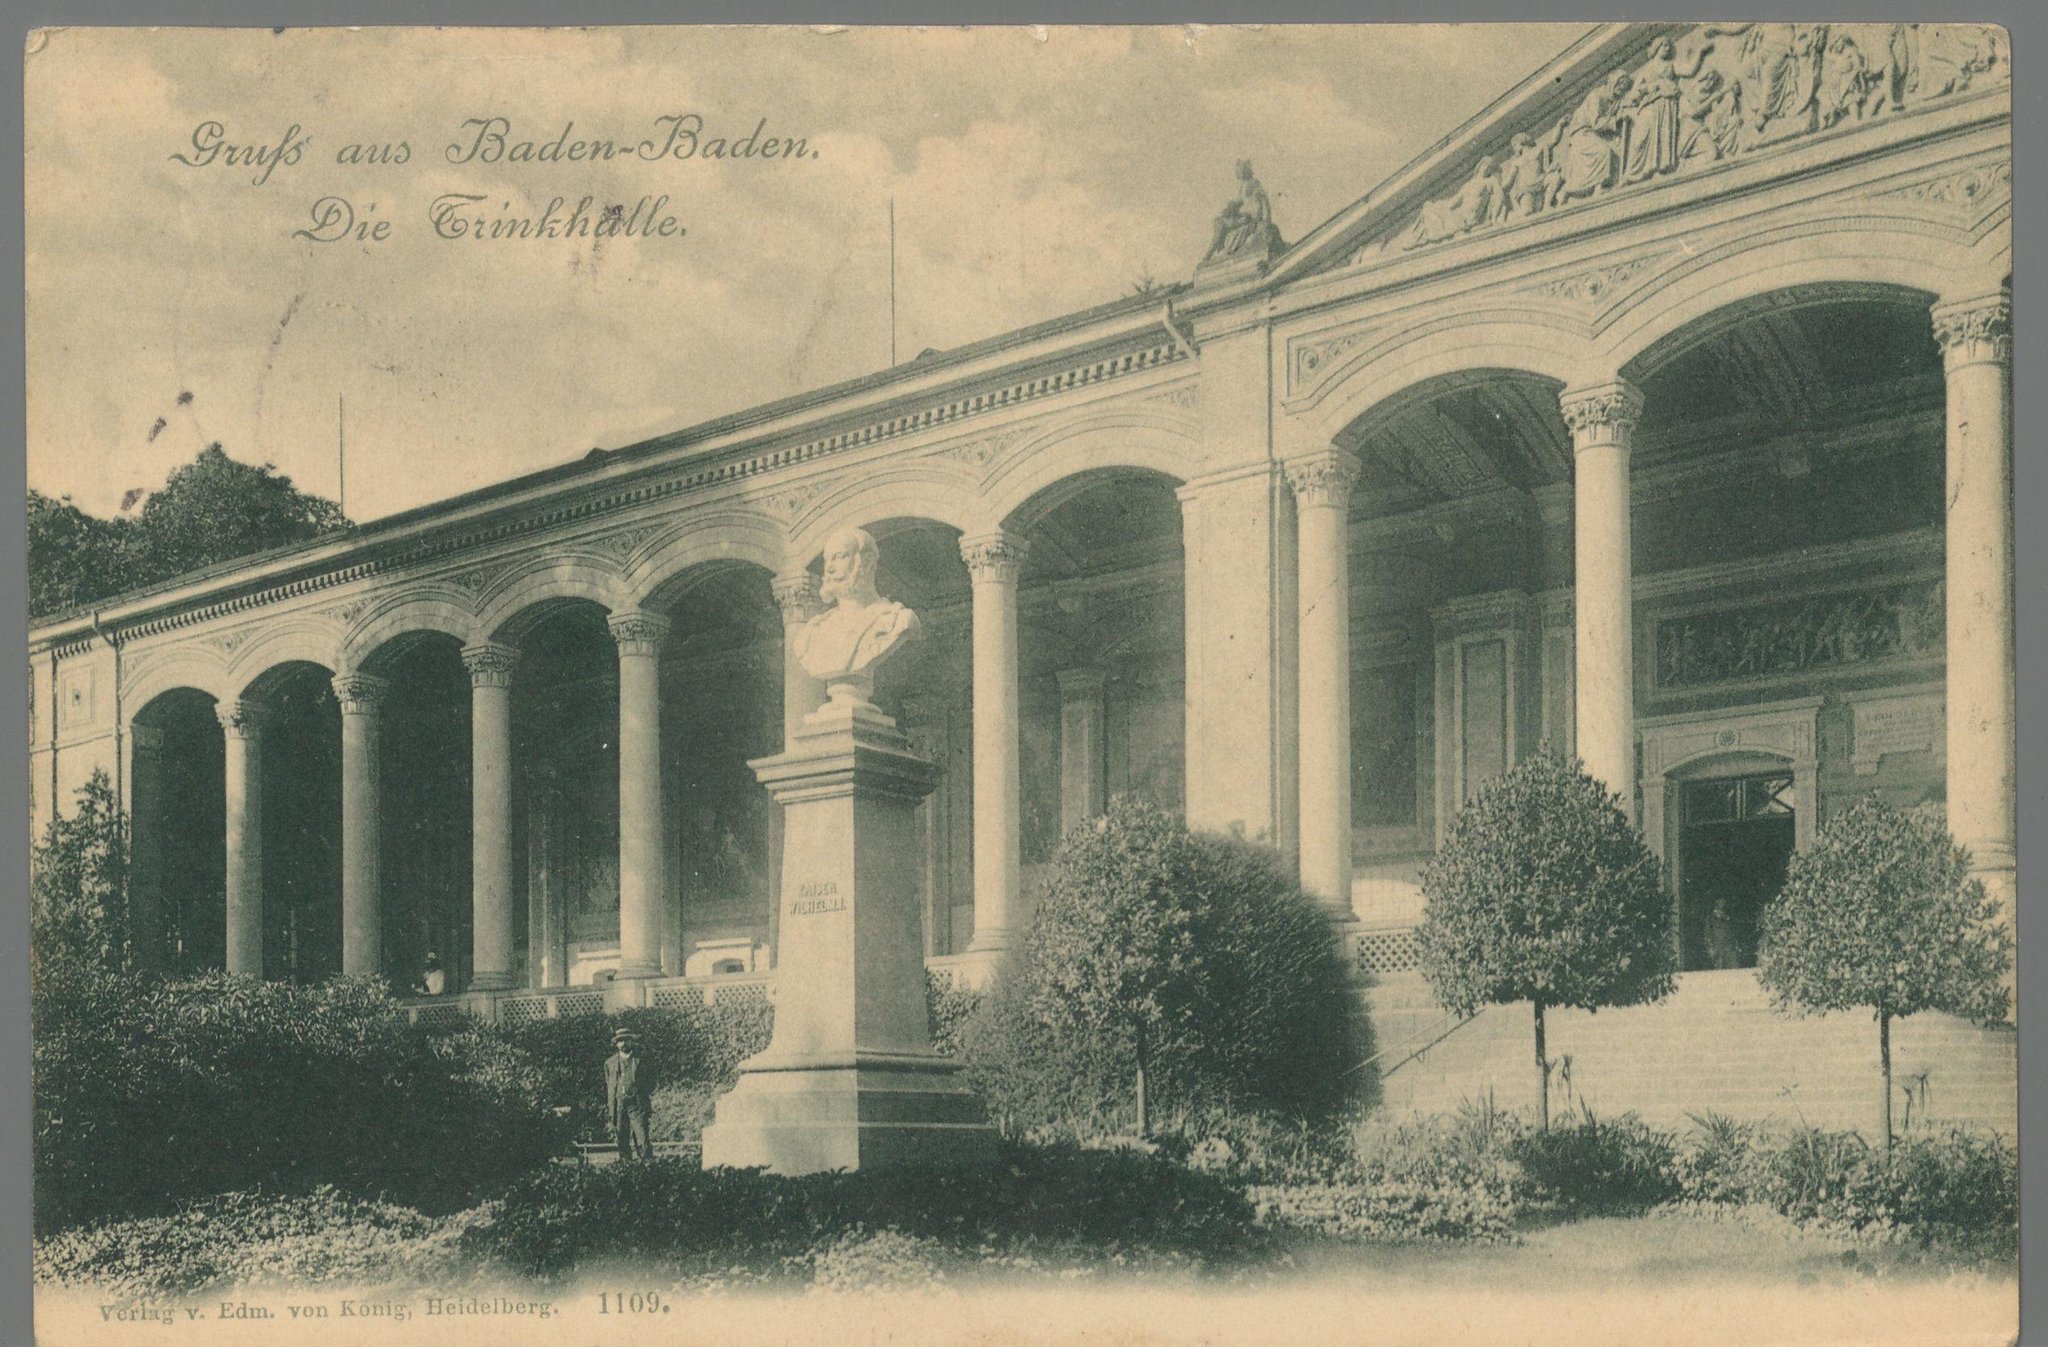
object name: ansichtkaart, prentbriefkaart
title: Gruss aus Baden-Baden. Die Trinkhalle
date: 1890-1903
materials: cardboard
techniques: photograph, writing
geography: heidelberg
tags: berlin, wilhelm i (keizer van duitsland), monument, statue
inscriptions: postage stamp